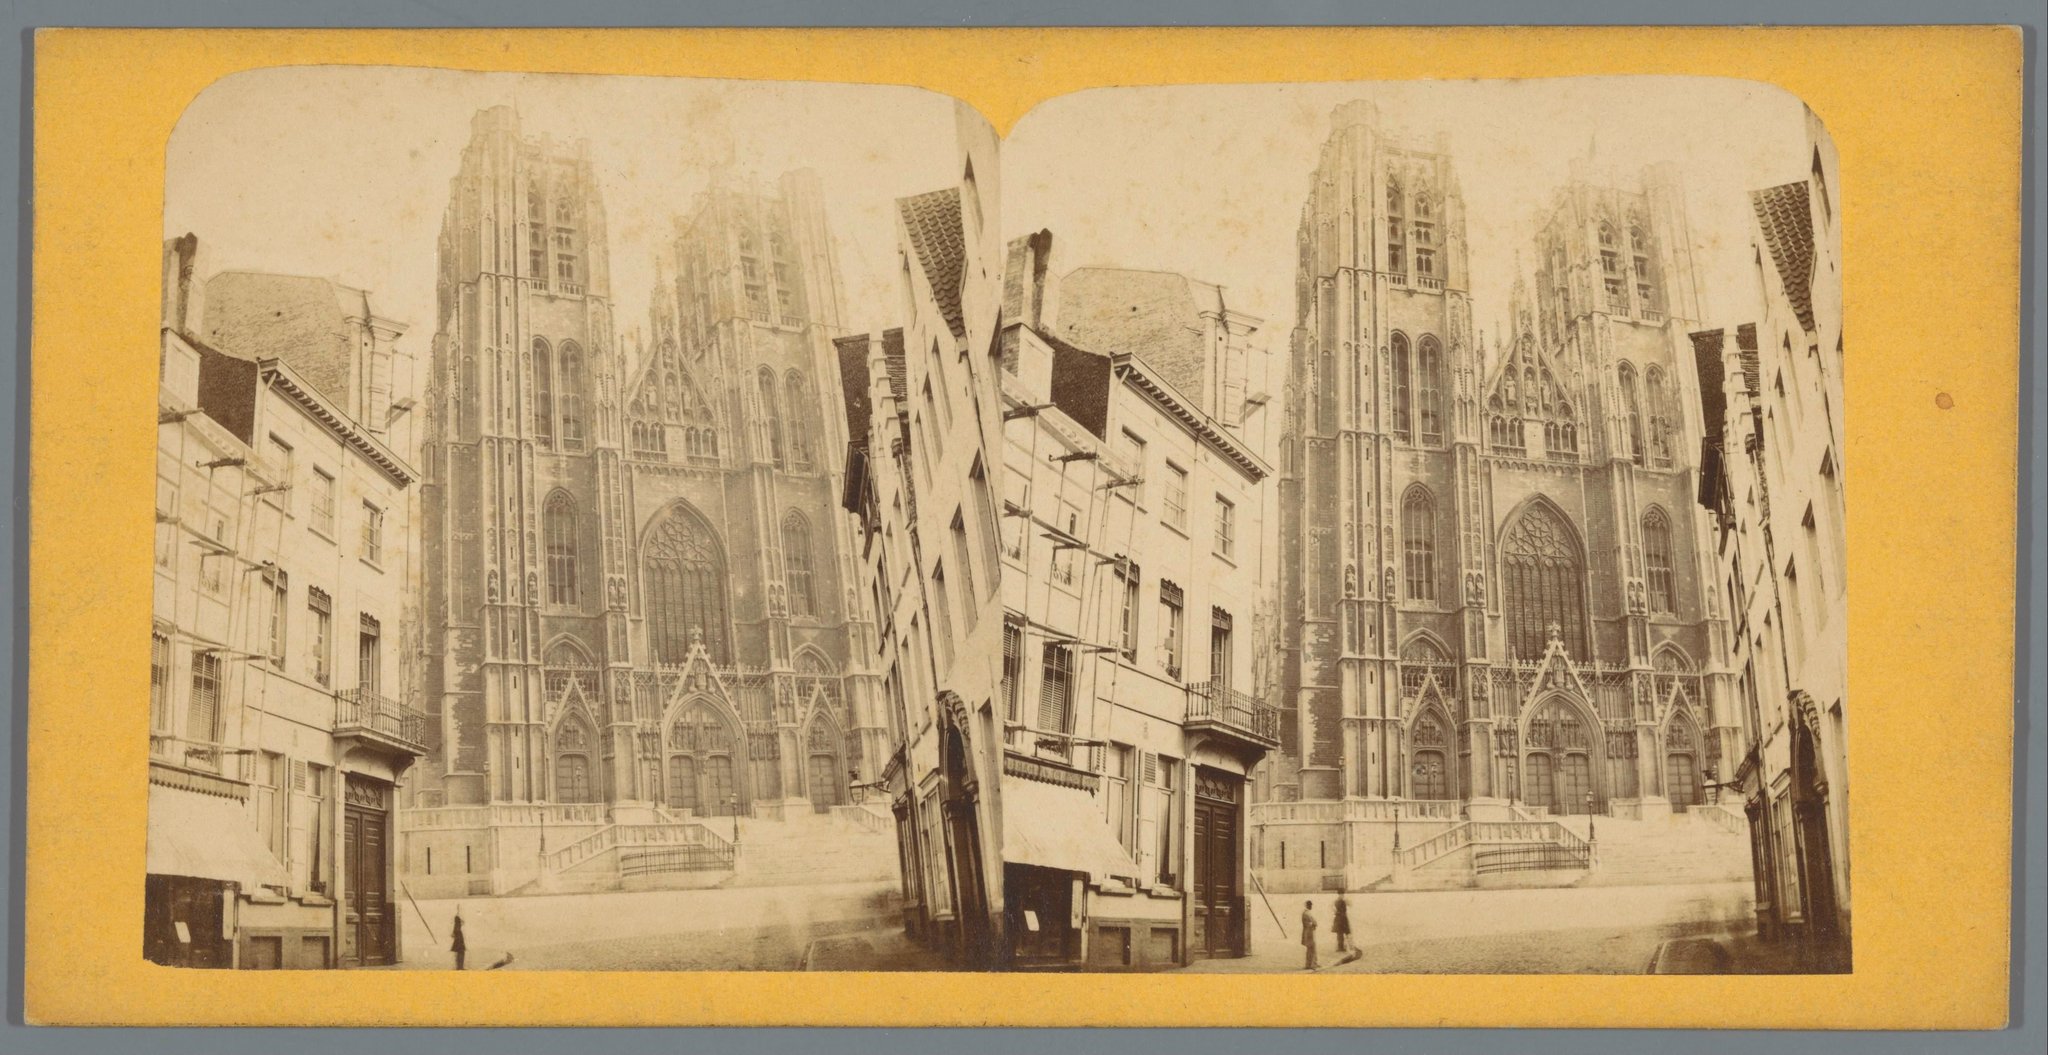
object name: stereograph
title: Gezicht op de façade van de Kathedraal van Sint-Michiel en Sint-Goedele in Brussel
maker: bt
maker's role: fotograaf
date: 1861-1870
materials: cardboard, paper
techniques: albumen print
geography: brussels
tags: parts of church exterior and annexes: portal, parts of church exterior and annexes: façade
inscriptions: inscription: ‘(Province de Brabant.)’, retailer's mark: ‘Nolet & Zoon/ Utrecht’, inscription: ‘3/ [...]’, number: ‘No 13 bis.’